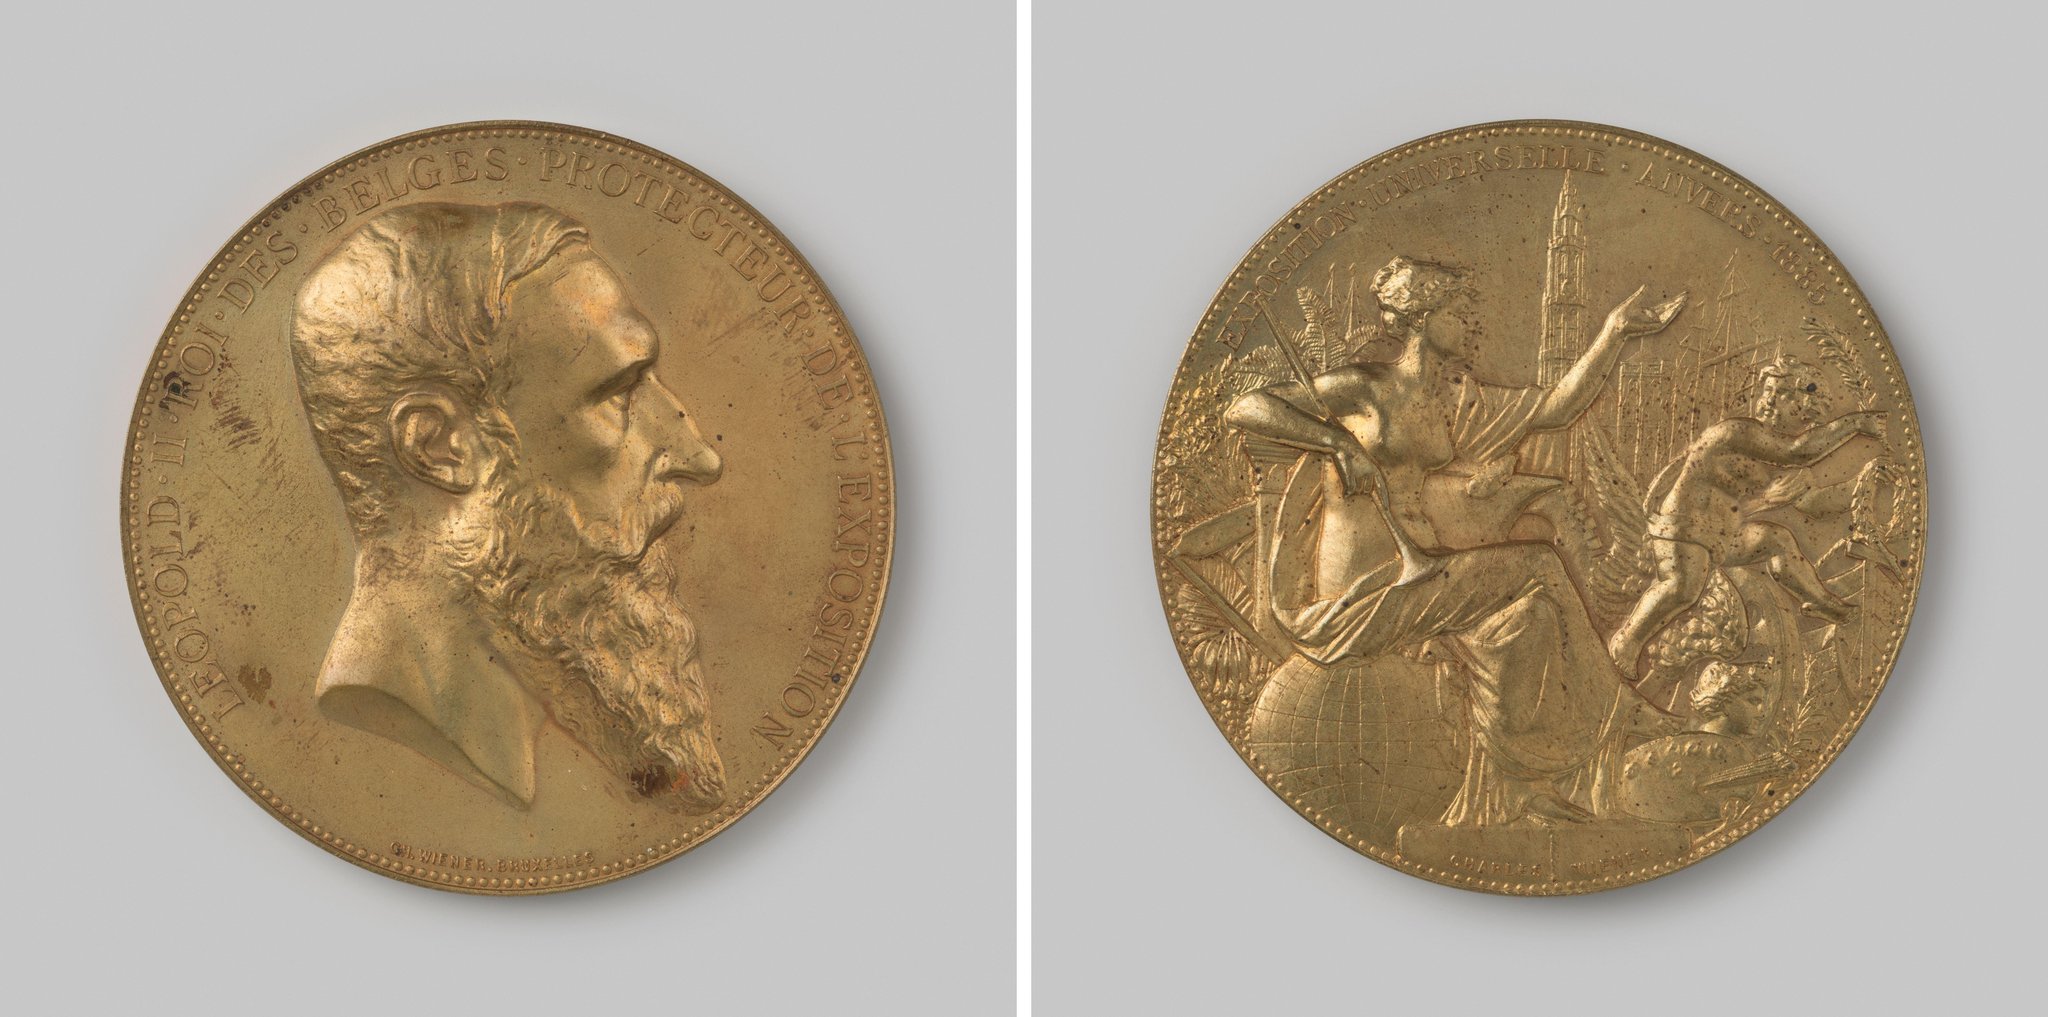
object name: history medal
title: Wereldtentoonstelling te Antwerpen met Koning Lodewijk II als beschermheer 1885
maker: karel wiener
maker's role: medailleur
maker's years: 1831-1888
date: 1885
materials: bronze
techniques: striking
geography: brussels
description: Bronzen penning, op de voorzijde het portret van Koning Leopold II naar rechts met omschrift, op de keerzijde een Faam met trompet zittend op een globe en gebarend naar een jongetje met krans en palmtak, te midden van symbolen van landbouw, nijverheid en kunst, met op de achtergrond Antwerpen en bovenaan omschrift.